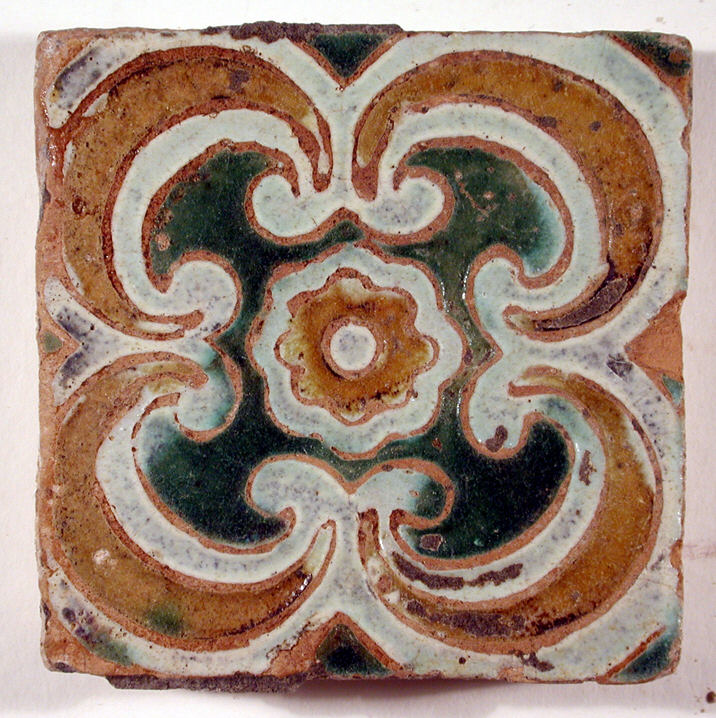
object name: pavement tile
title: Pavement tiles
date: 1501-1700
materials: earthenware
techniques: glazing